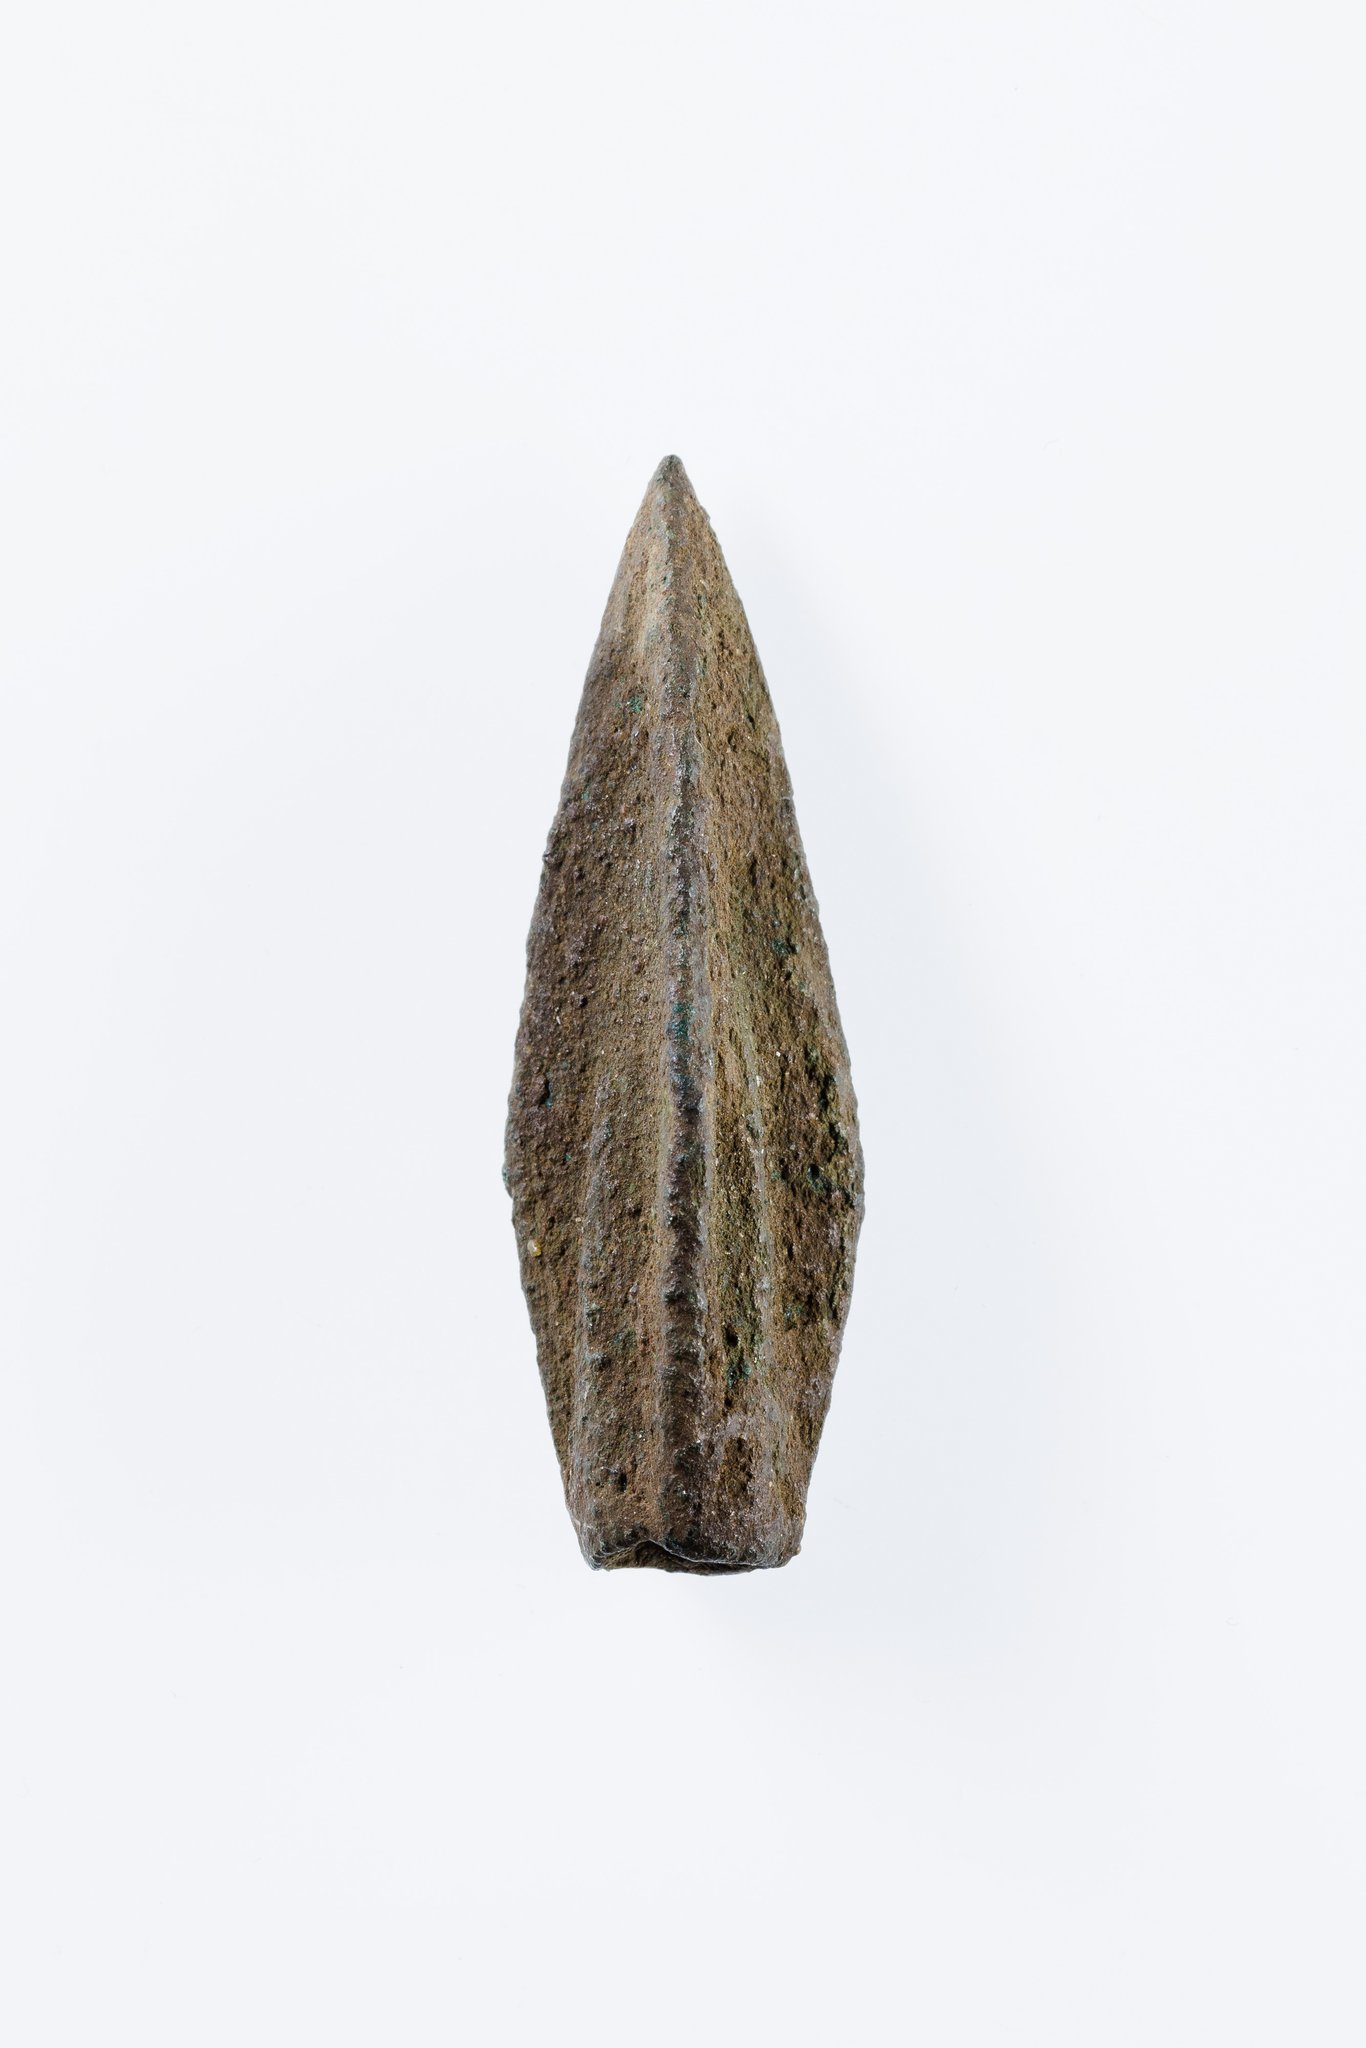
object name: arrow point, apries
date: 589-570 BCE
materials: bronze, copper alloy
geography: egypt